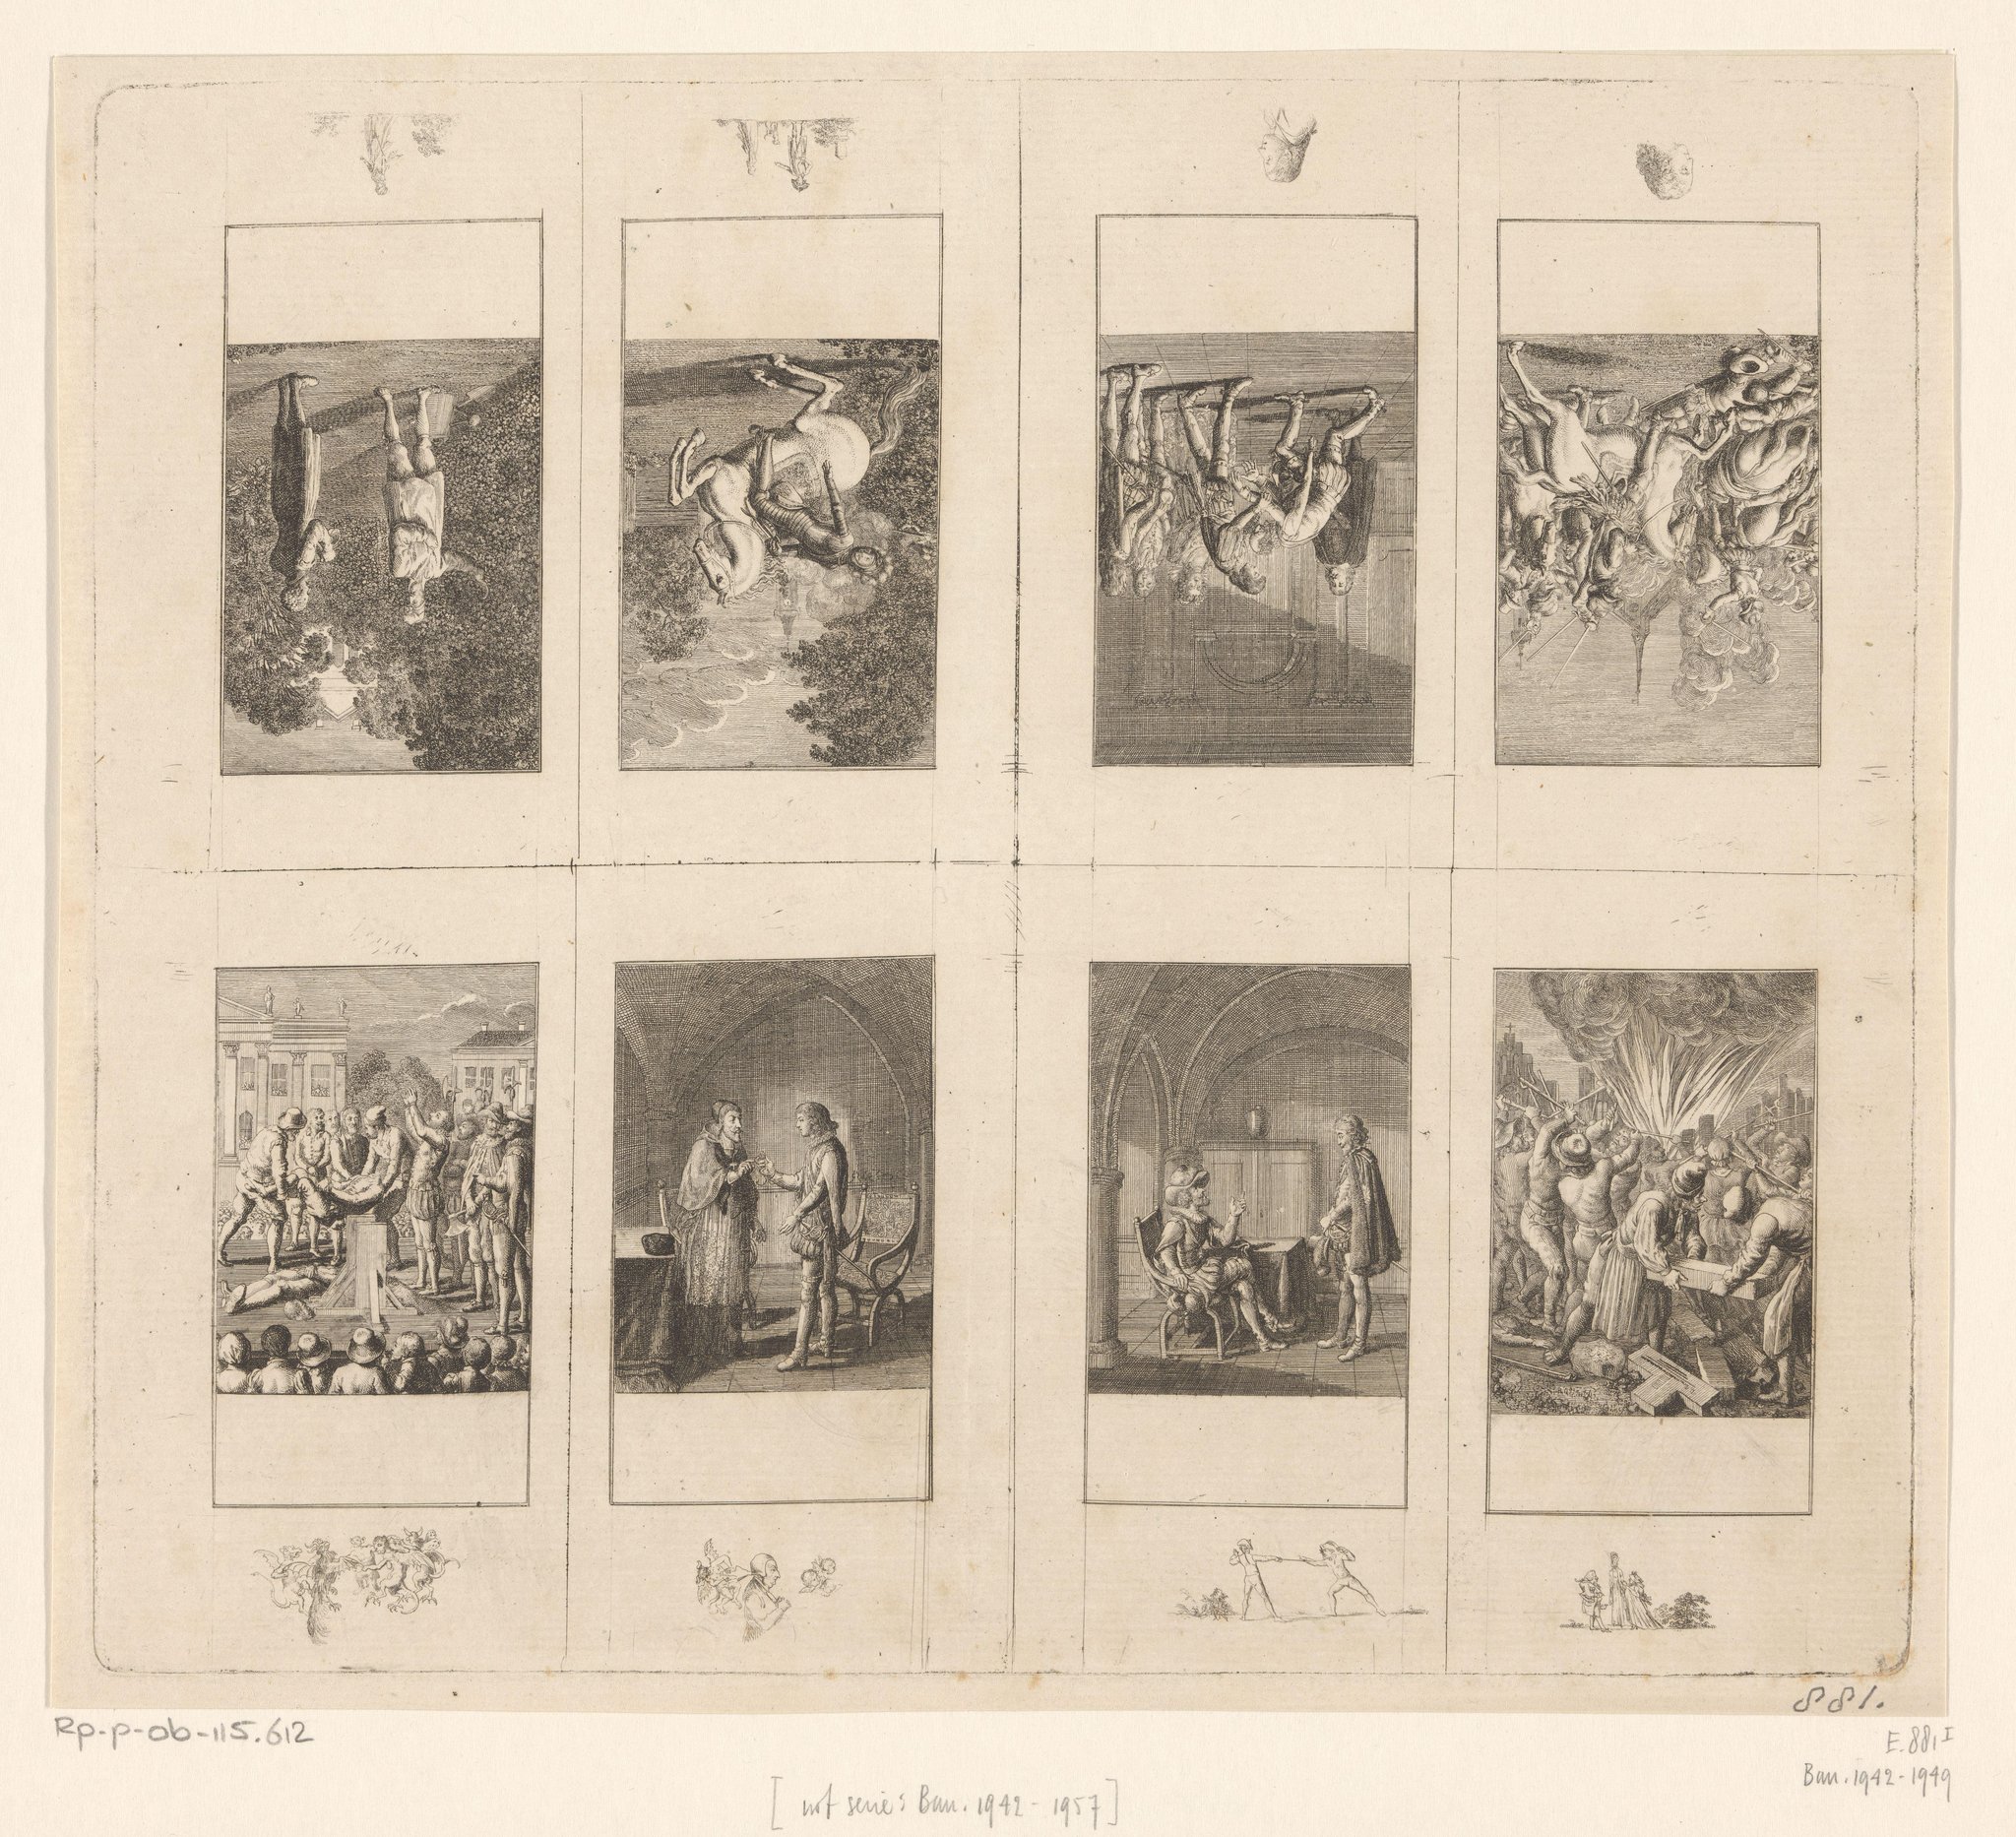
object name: print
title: Acht voorstellingen uit de geschiedenis van de Bartholomeusnacht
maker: daniel nikolaus chodowiecki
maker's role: draughtsman, print maker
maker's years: 1726-1801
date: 1798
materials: paper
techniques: etching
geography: berlin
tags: politician, gaspard de coligny (ii), paris, hendrik iv (koning van frankrijk en navarra), introducing, riding a horse, ass, or mule; rider, horseman, on fire, ablaze, cross as symbol of christ, (military) espionage, wine production, battle, murder, ring, kneeling figure, fighting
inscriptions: collector's mark: Lugt 2228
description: Prenten gebruikt voor: Historisch-genealogischer Kalender auf das Jahr 1799 und 1800. Die Geschichte der Bartholomäusnacht oder die Bluthochzeit zu Paris. Berlijn: Johann Friedrich Unger, [1798].